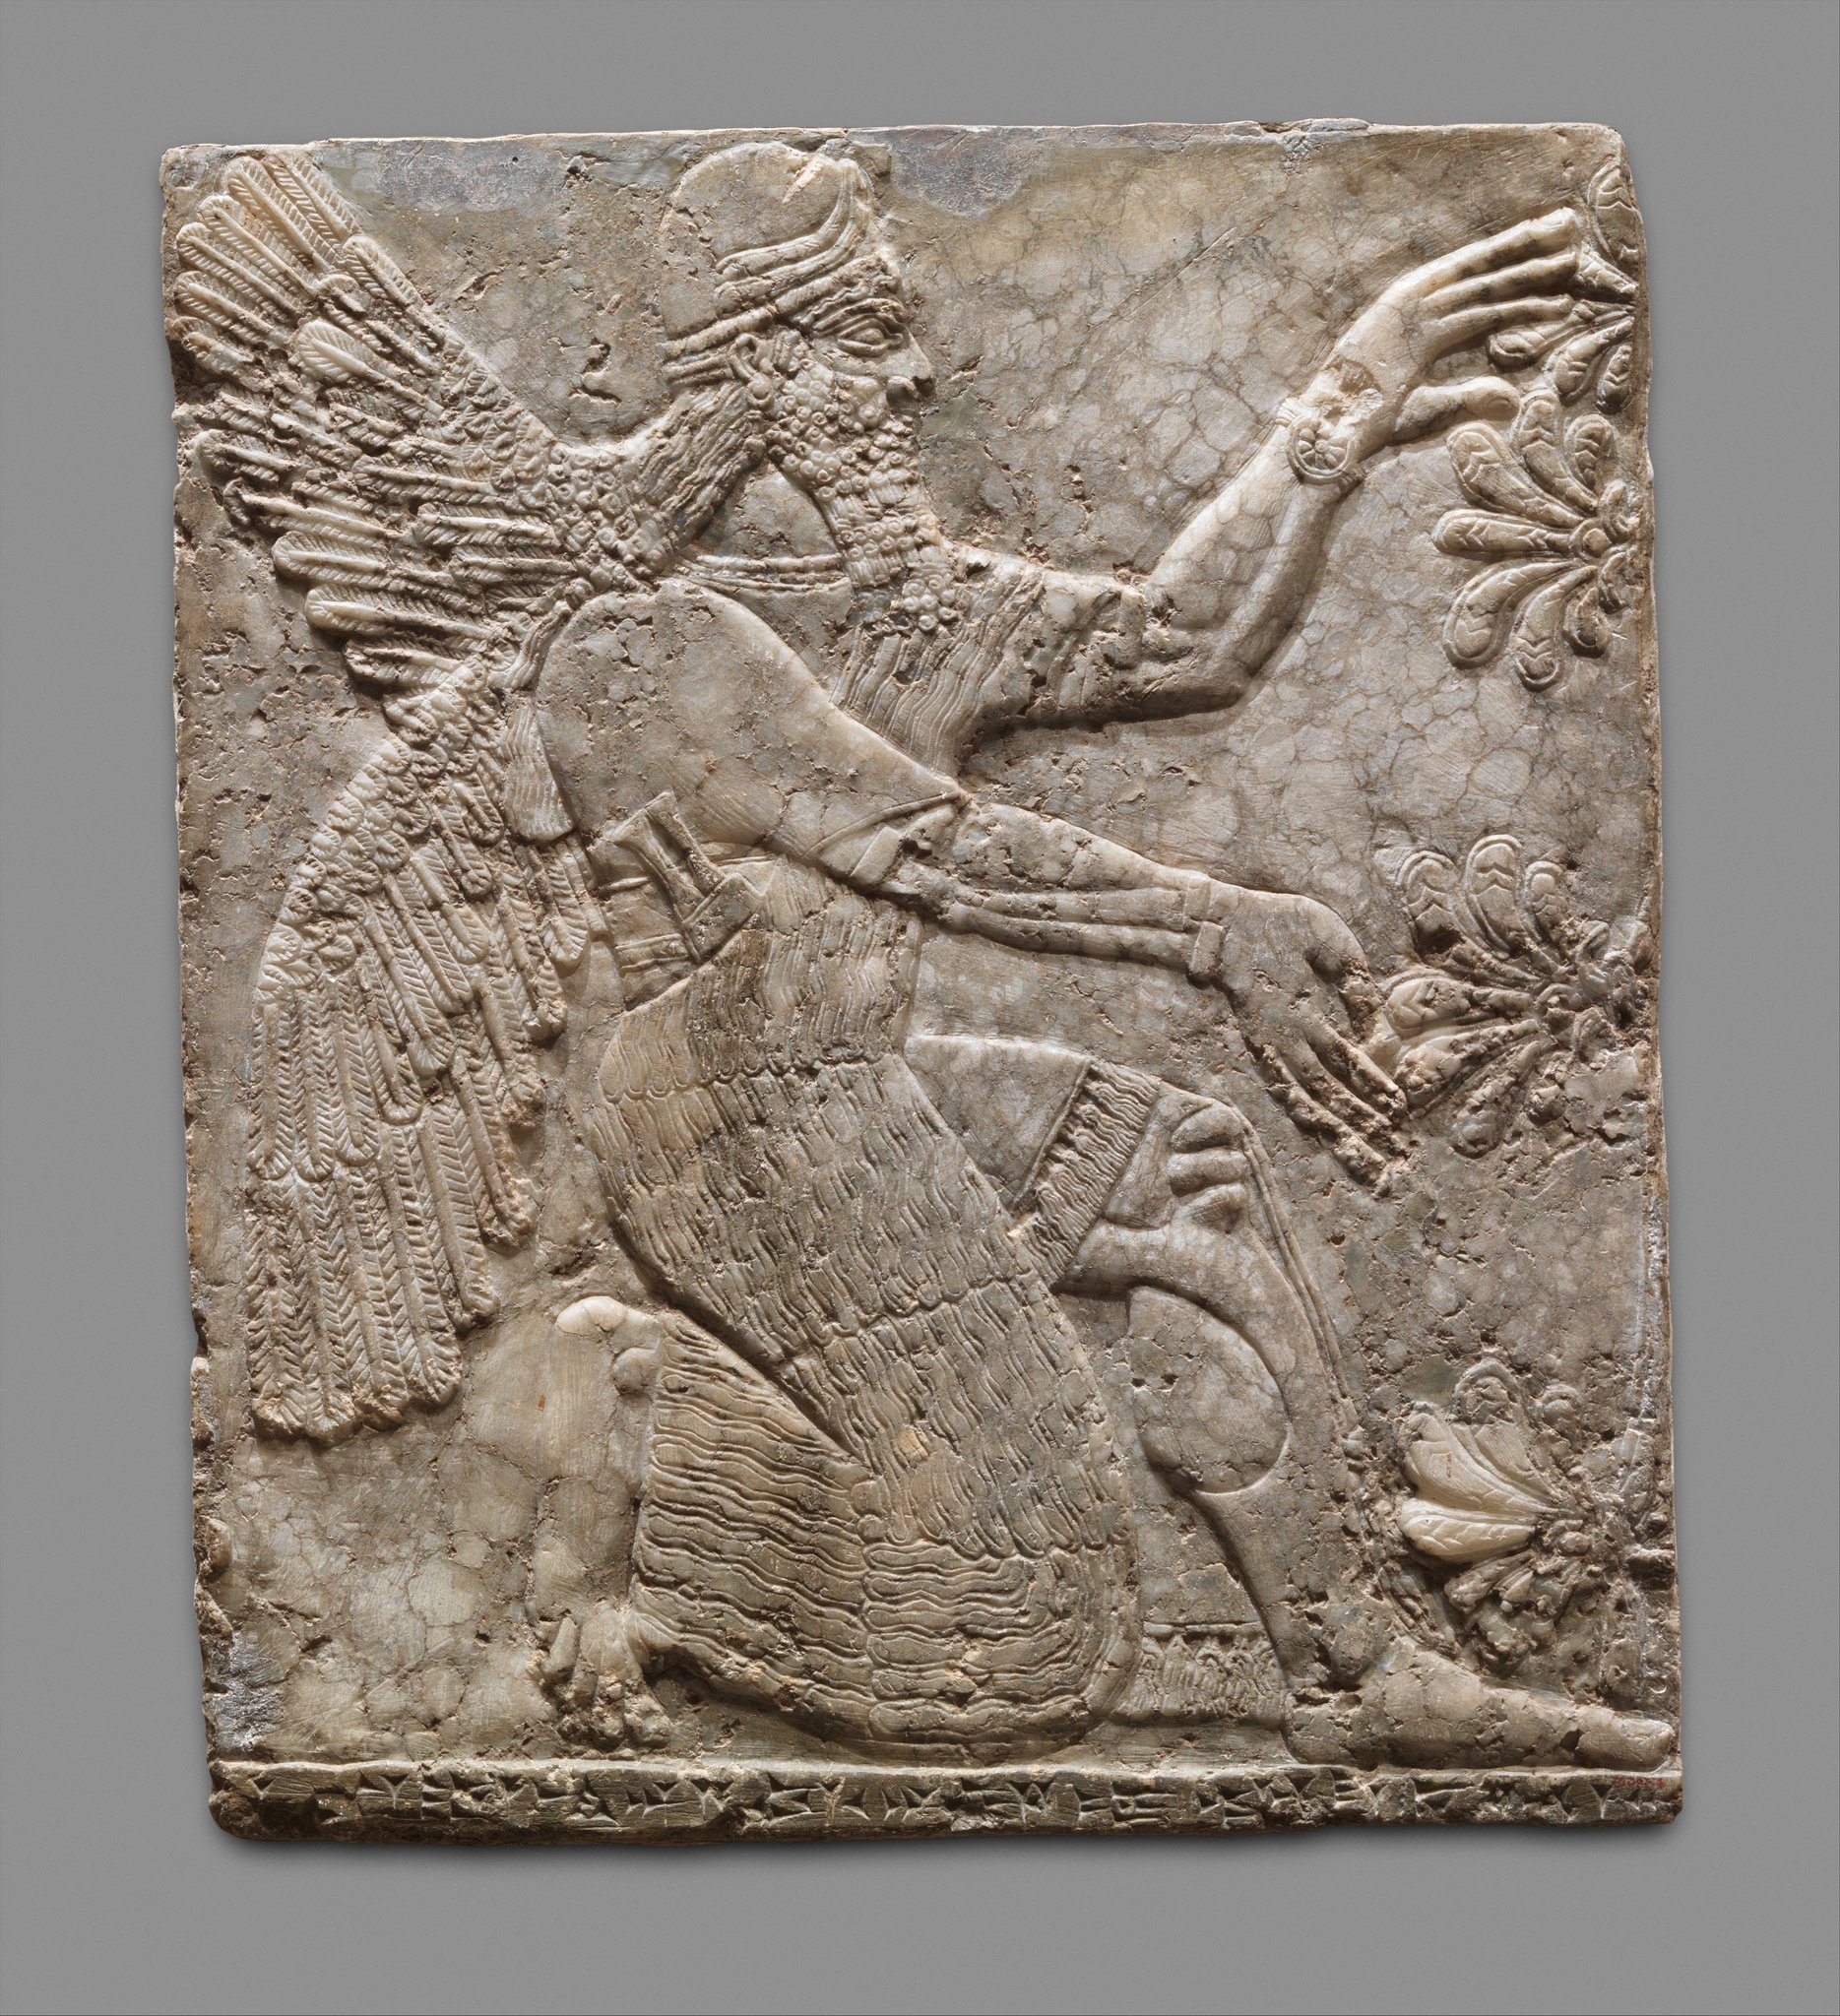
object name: relief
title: Relief panel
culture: assyrian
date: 883-859 BCE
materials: alabaster, gypsum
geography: mesopotamia